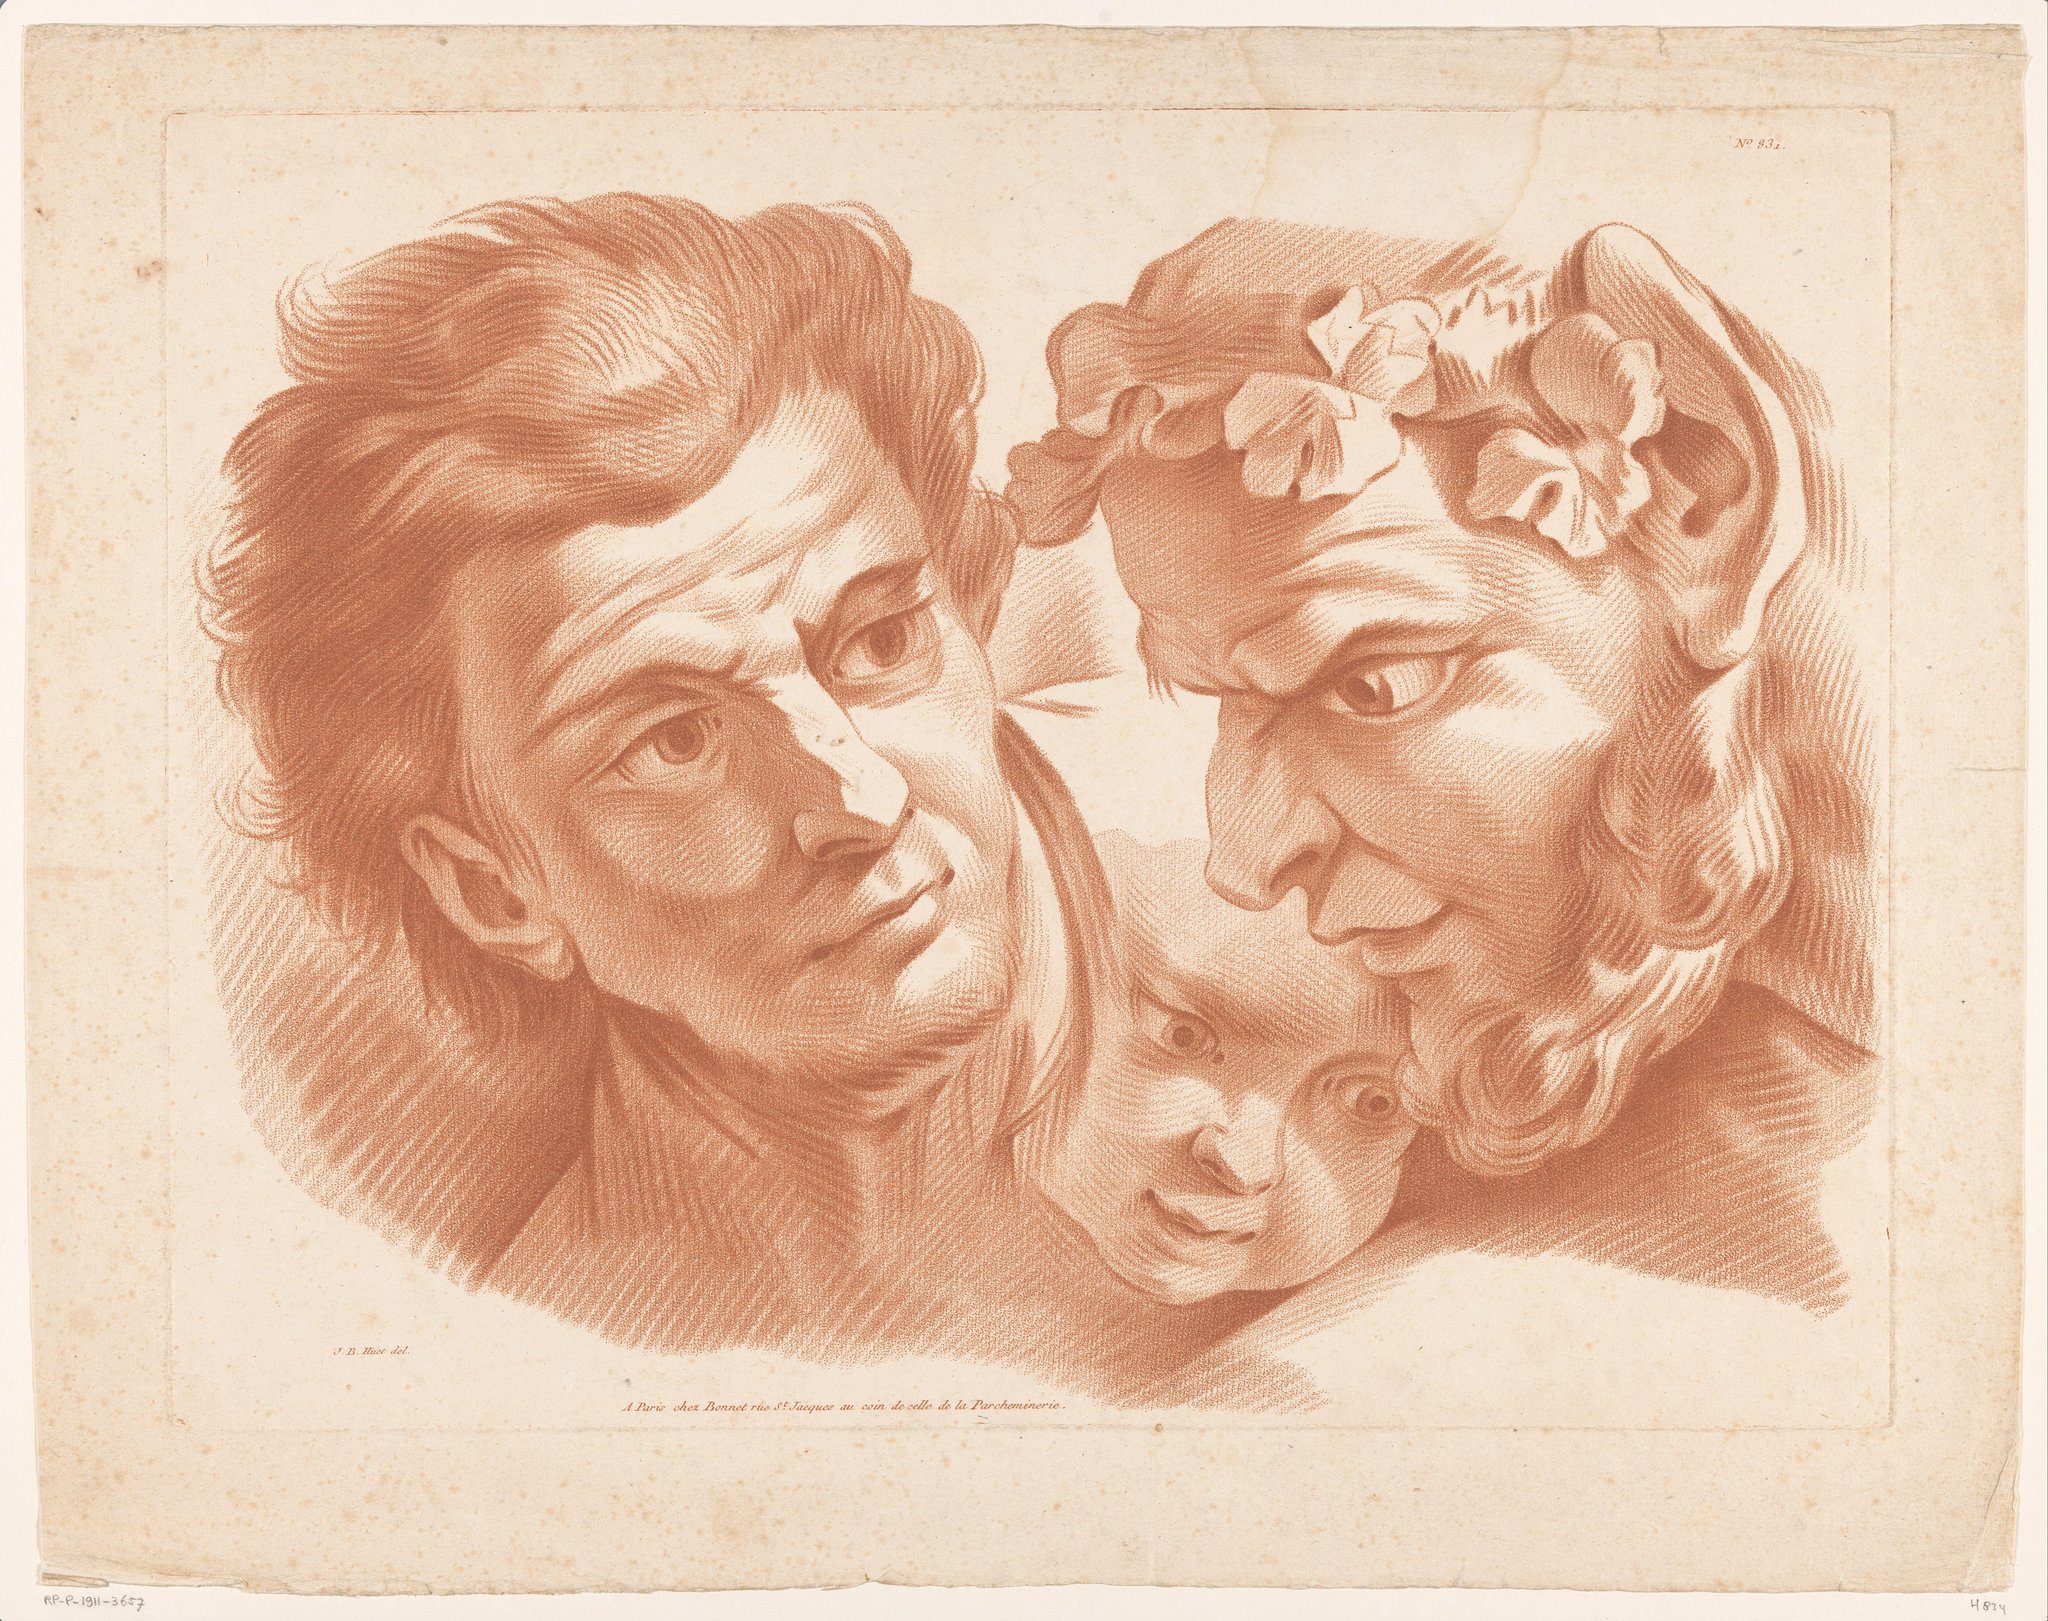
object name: print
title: Drie hoofden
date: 1746-1793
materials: paper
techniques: printmaking, etching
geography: paris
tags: head (human), satyrs, fauns, sileni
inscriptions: collector's mark: Lugt 2228